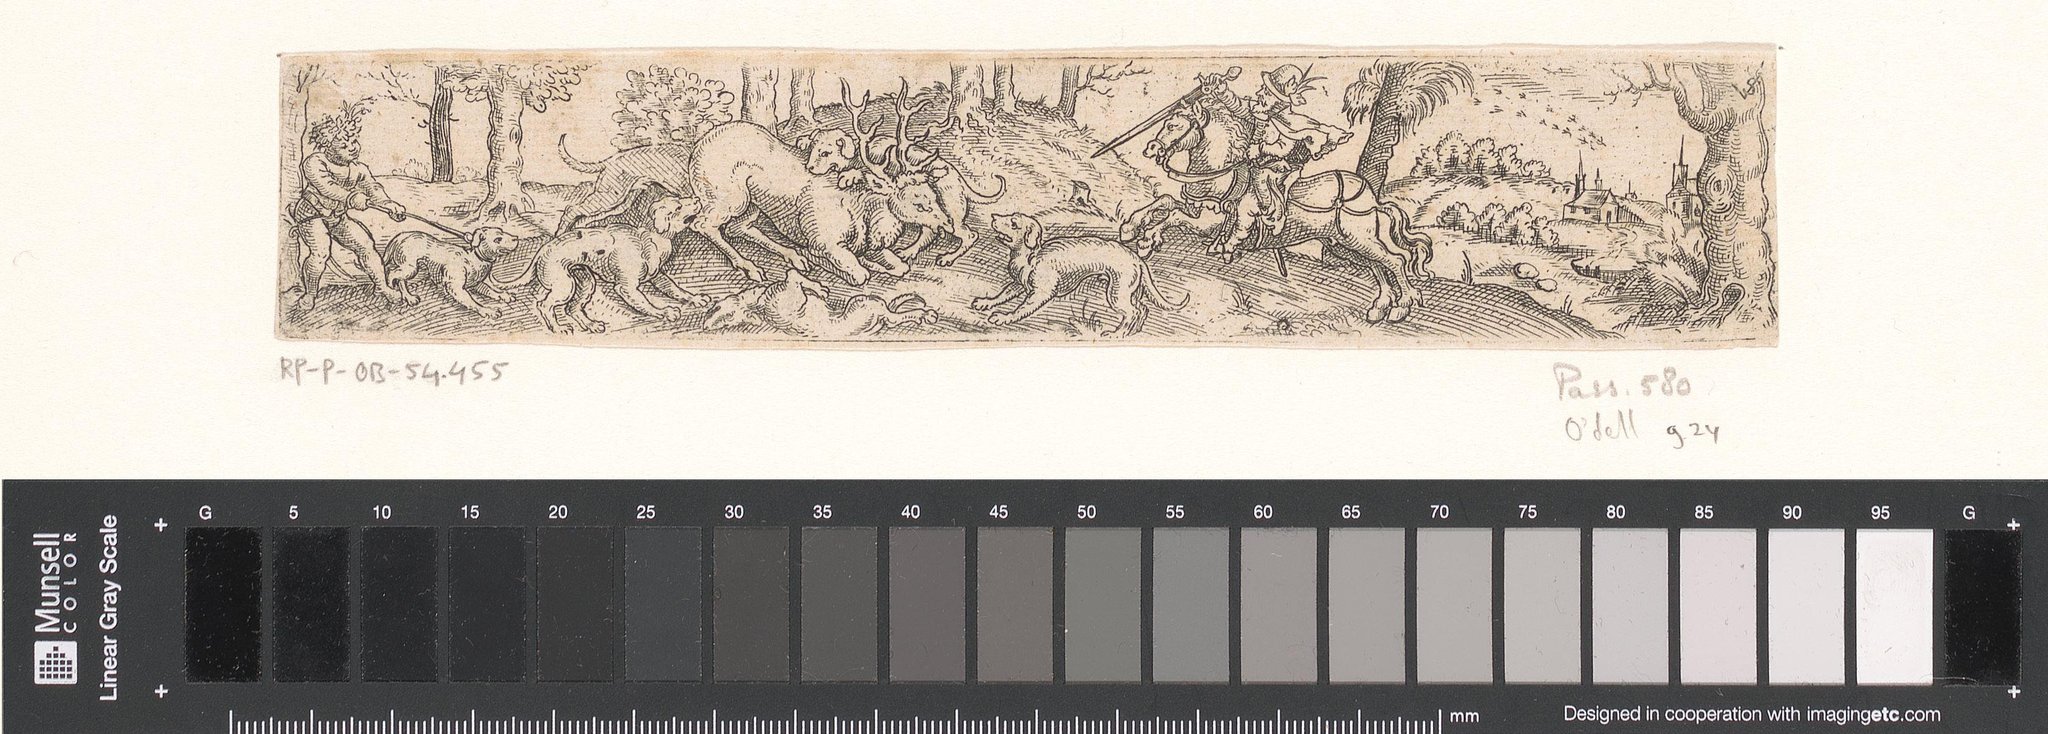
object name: print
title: Hertenjacht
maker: virgilius solis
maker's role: draughtsman, print maker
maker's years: 1514-1562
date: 1524-1562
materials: paper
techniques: engraving, etching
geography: nuremberg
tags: riding a horse, ass, or mule; rider, horseman, city-view, and landscape with man-made constructions, stag-hunting, hunting dogs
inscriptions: collector's mark: Lugt 2228, number: ‘34’